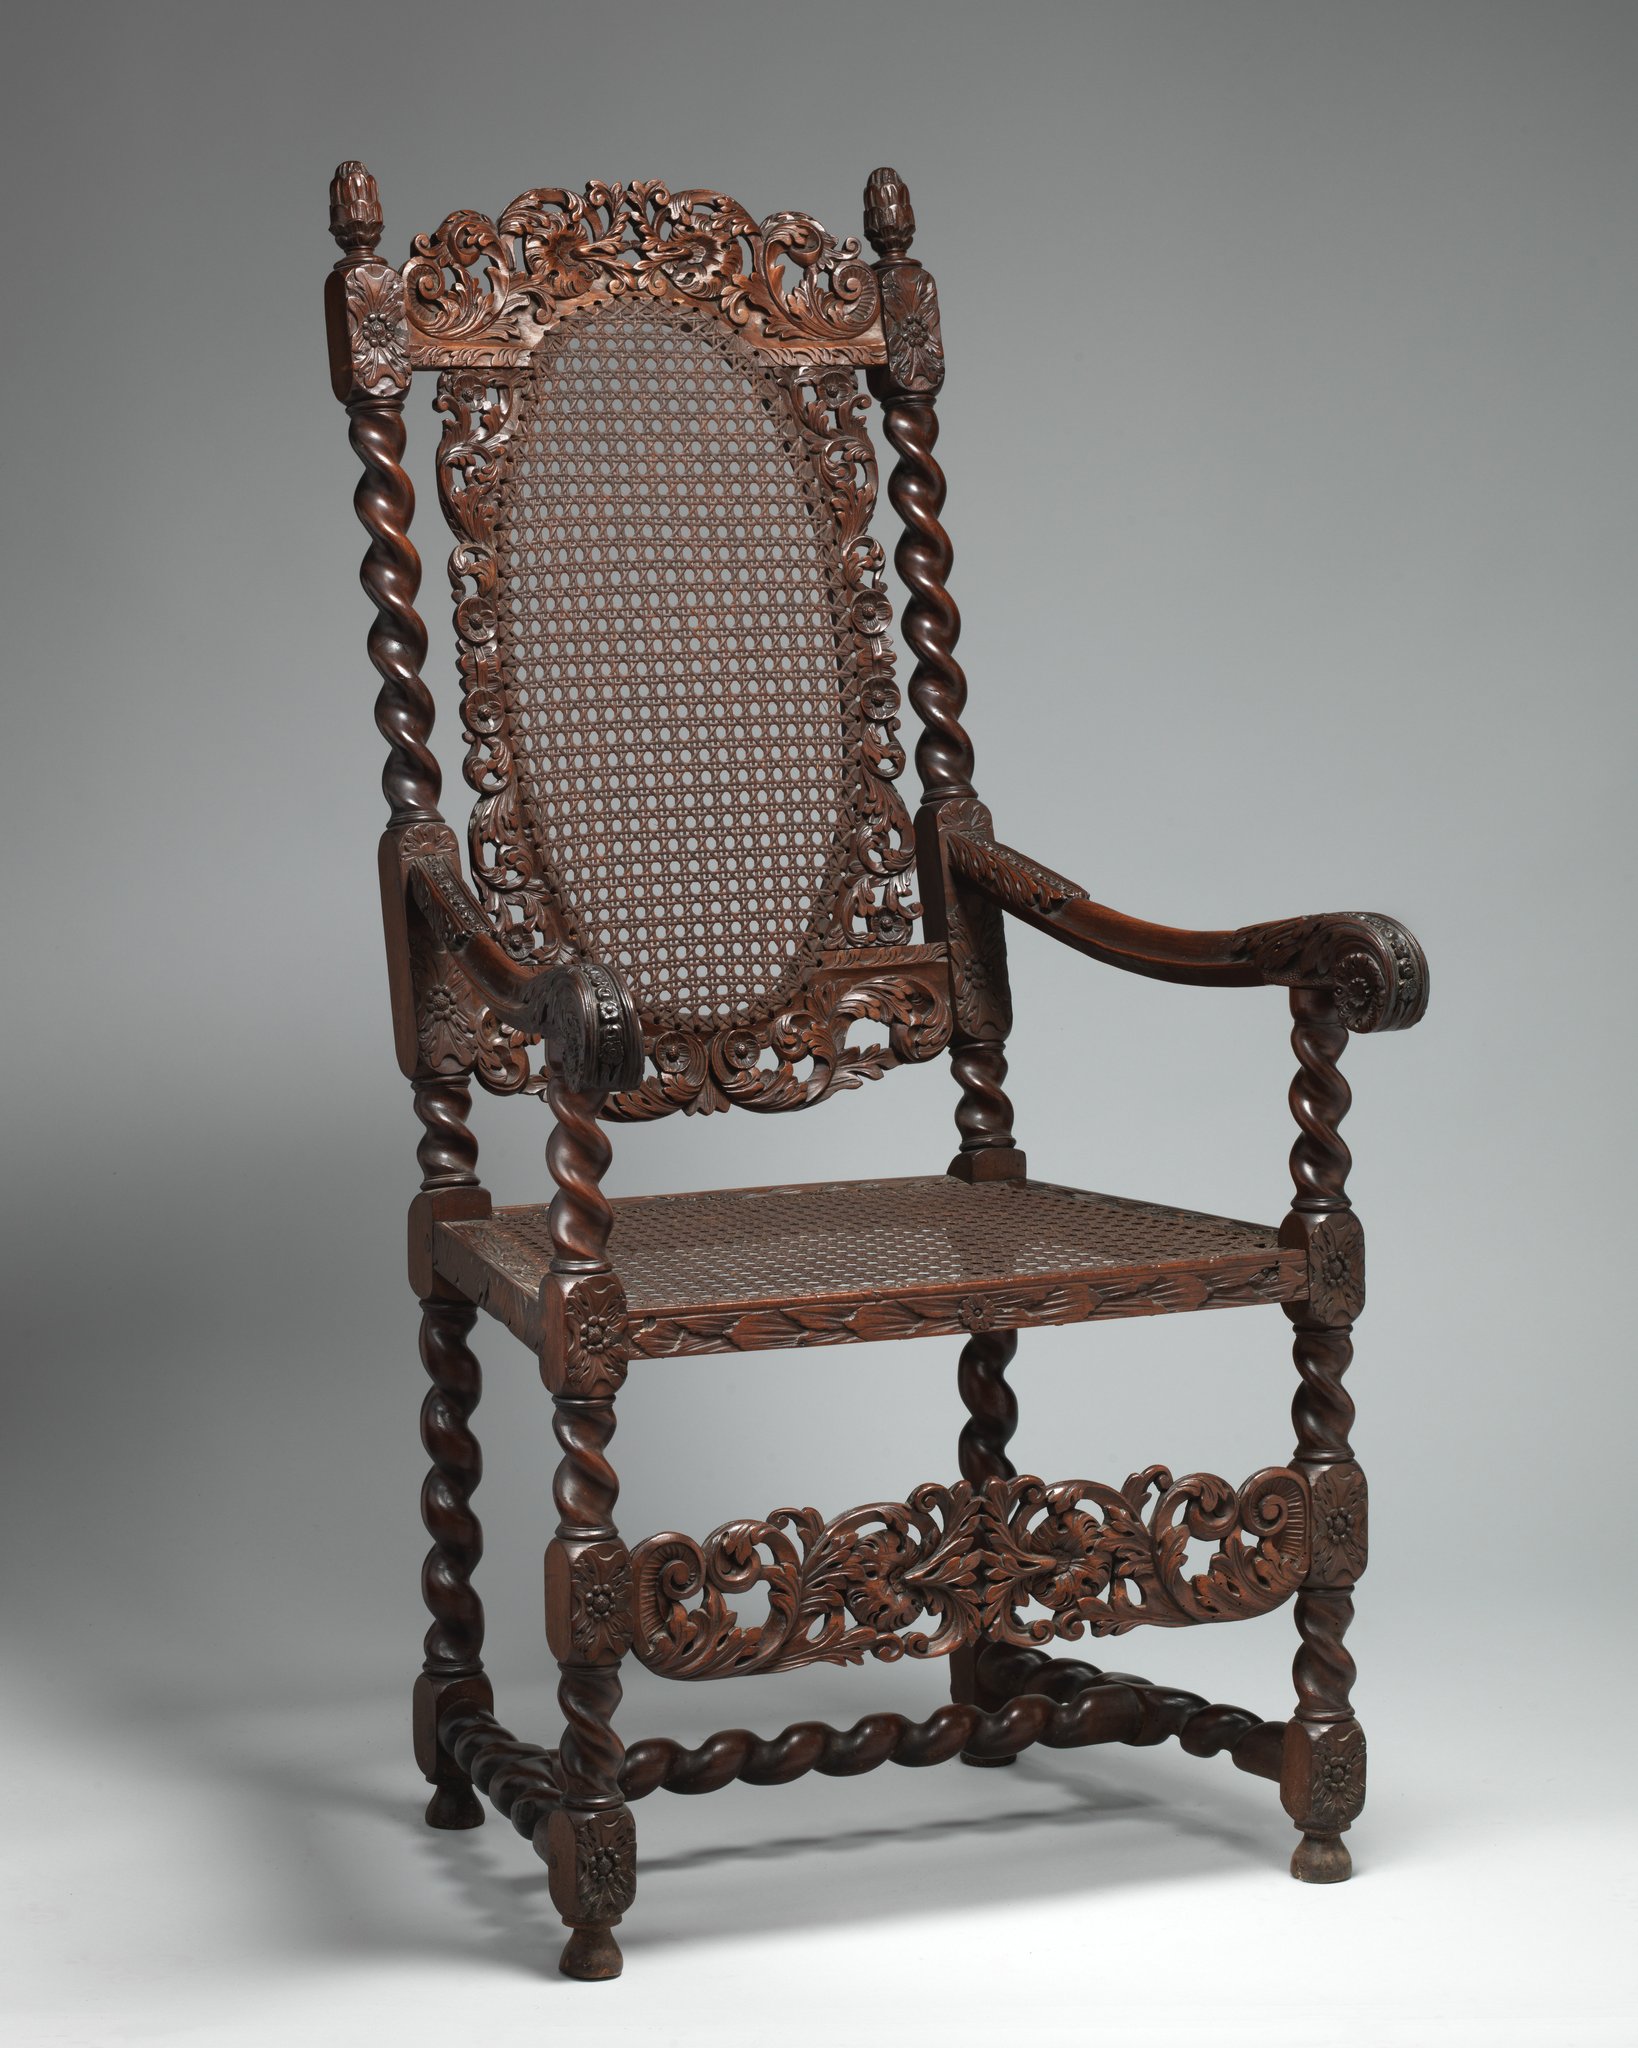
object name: armchair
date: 1680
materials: wood